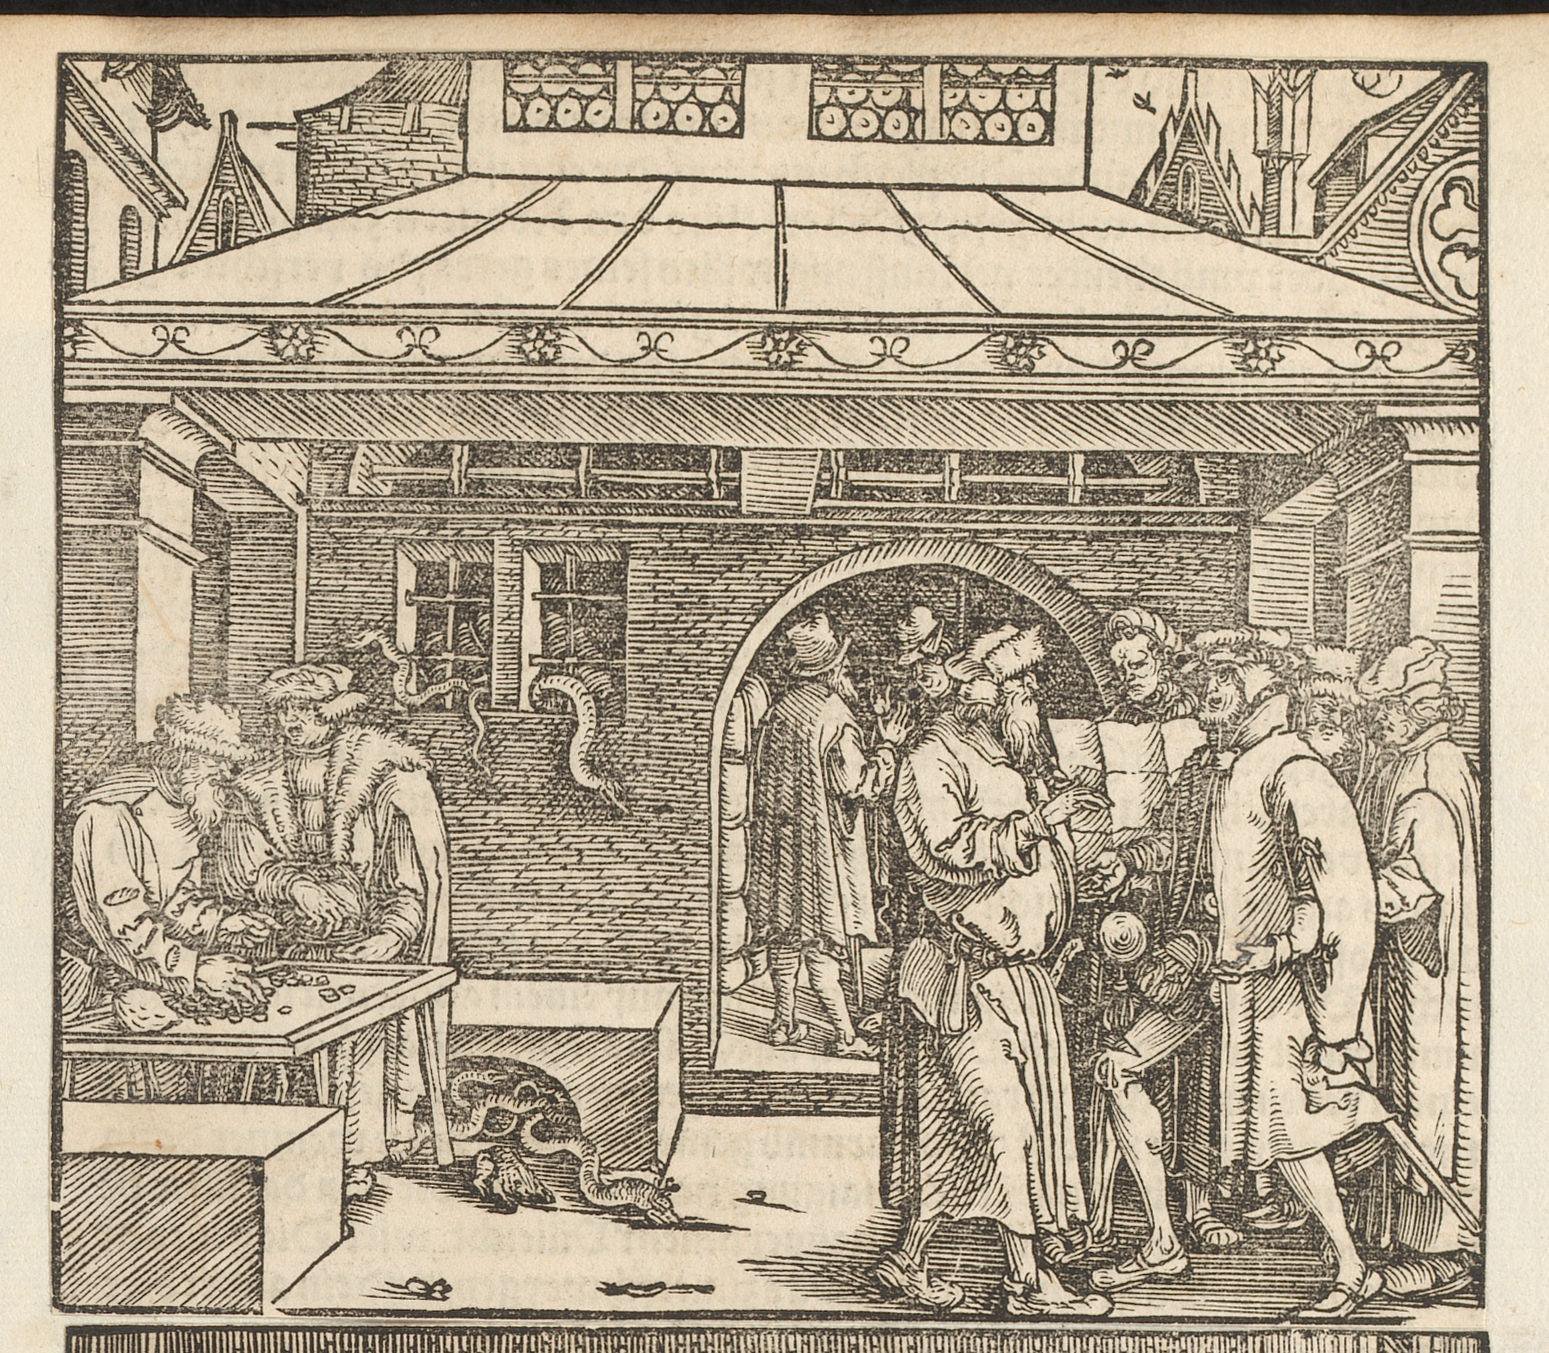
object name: album leaf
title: Mannen verkopen een huis waar slangen uit komen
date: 1514-1531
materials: paper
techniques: letterpress printing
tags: fraudulence, swindling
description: Deze prent is gebruikt in: Cicero, Marcus Tulius. Officia M.T.C. Ein Buch so Marcus Tullius Cicero der Römer zu seynem (...). [Vertaald uit het Latijn door] Johann von Schwarzenberg. Augsburg: Heinrich Steiner, 1531.